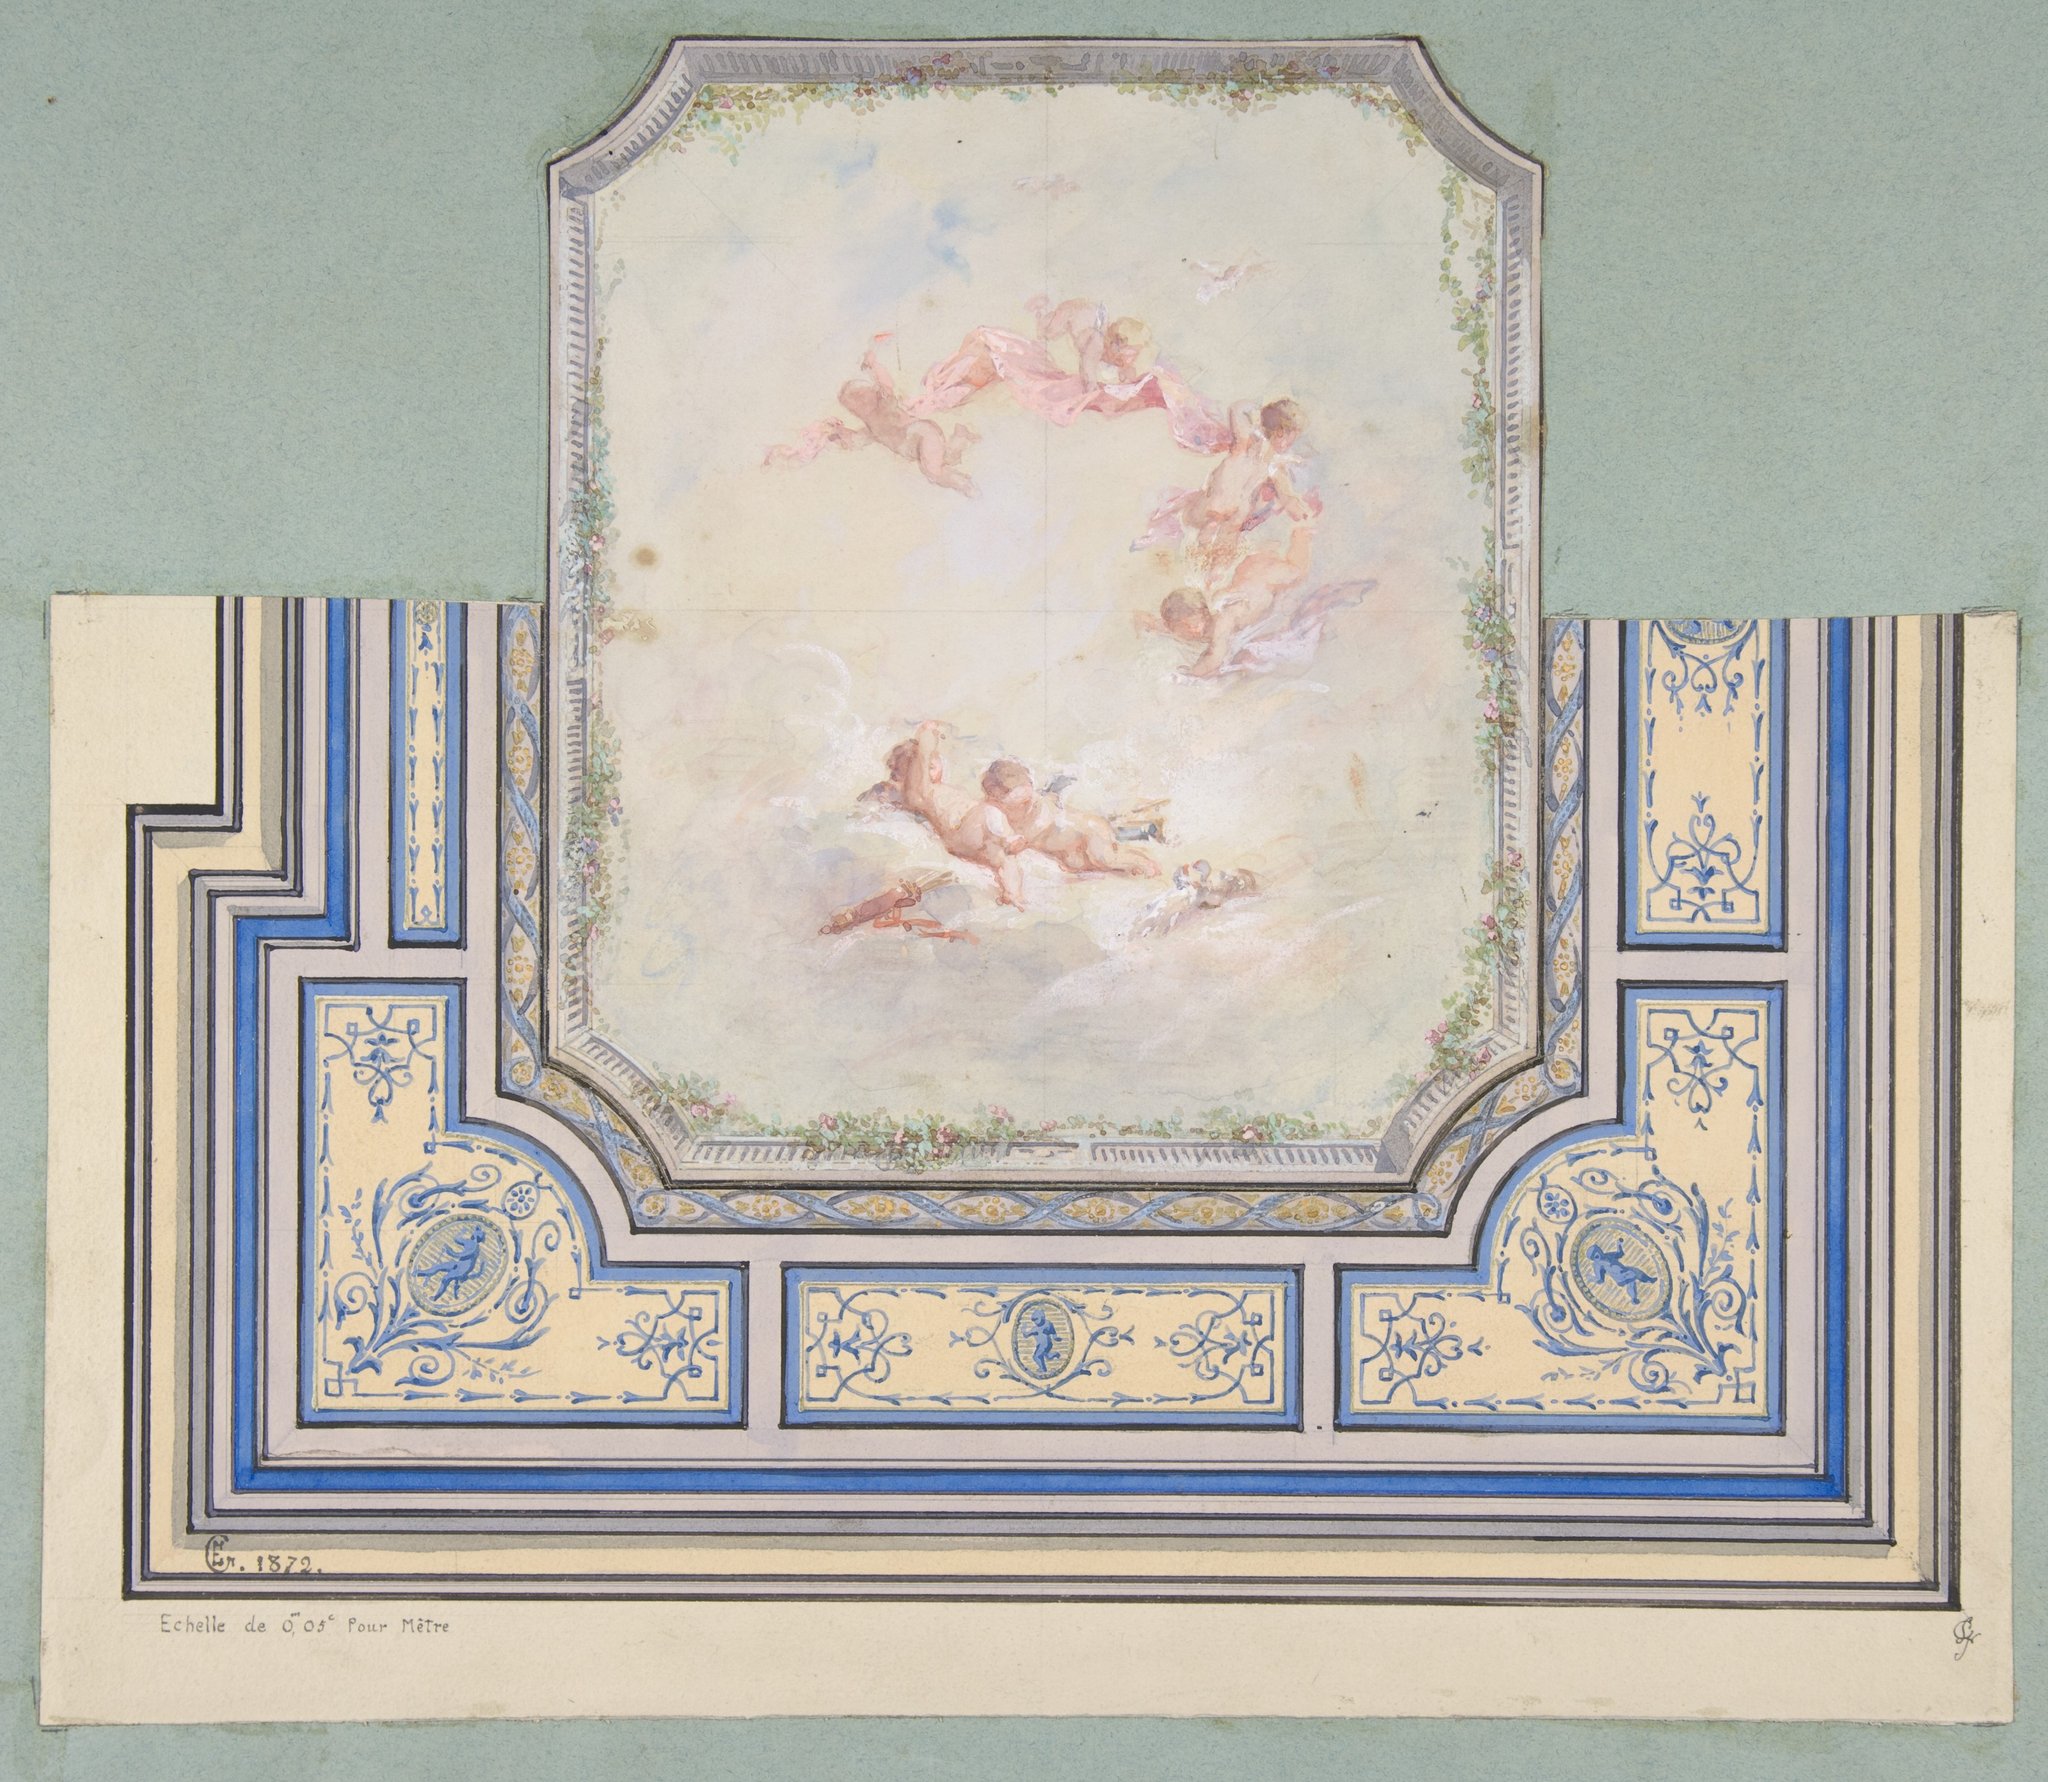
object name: drawing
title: Design for Ceiling with Putti, Hôtel of Doctor Cranchi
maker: jules-edmond-charles lachaise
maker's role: artist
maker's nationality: french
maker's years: 1897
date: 1872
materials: gouache, watercolor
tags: ornament,putti,ceilings